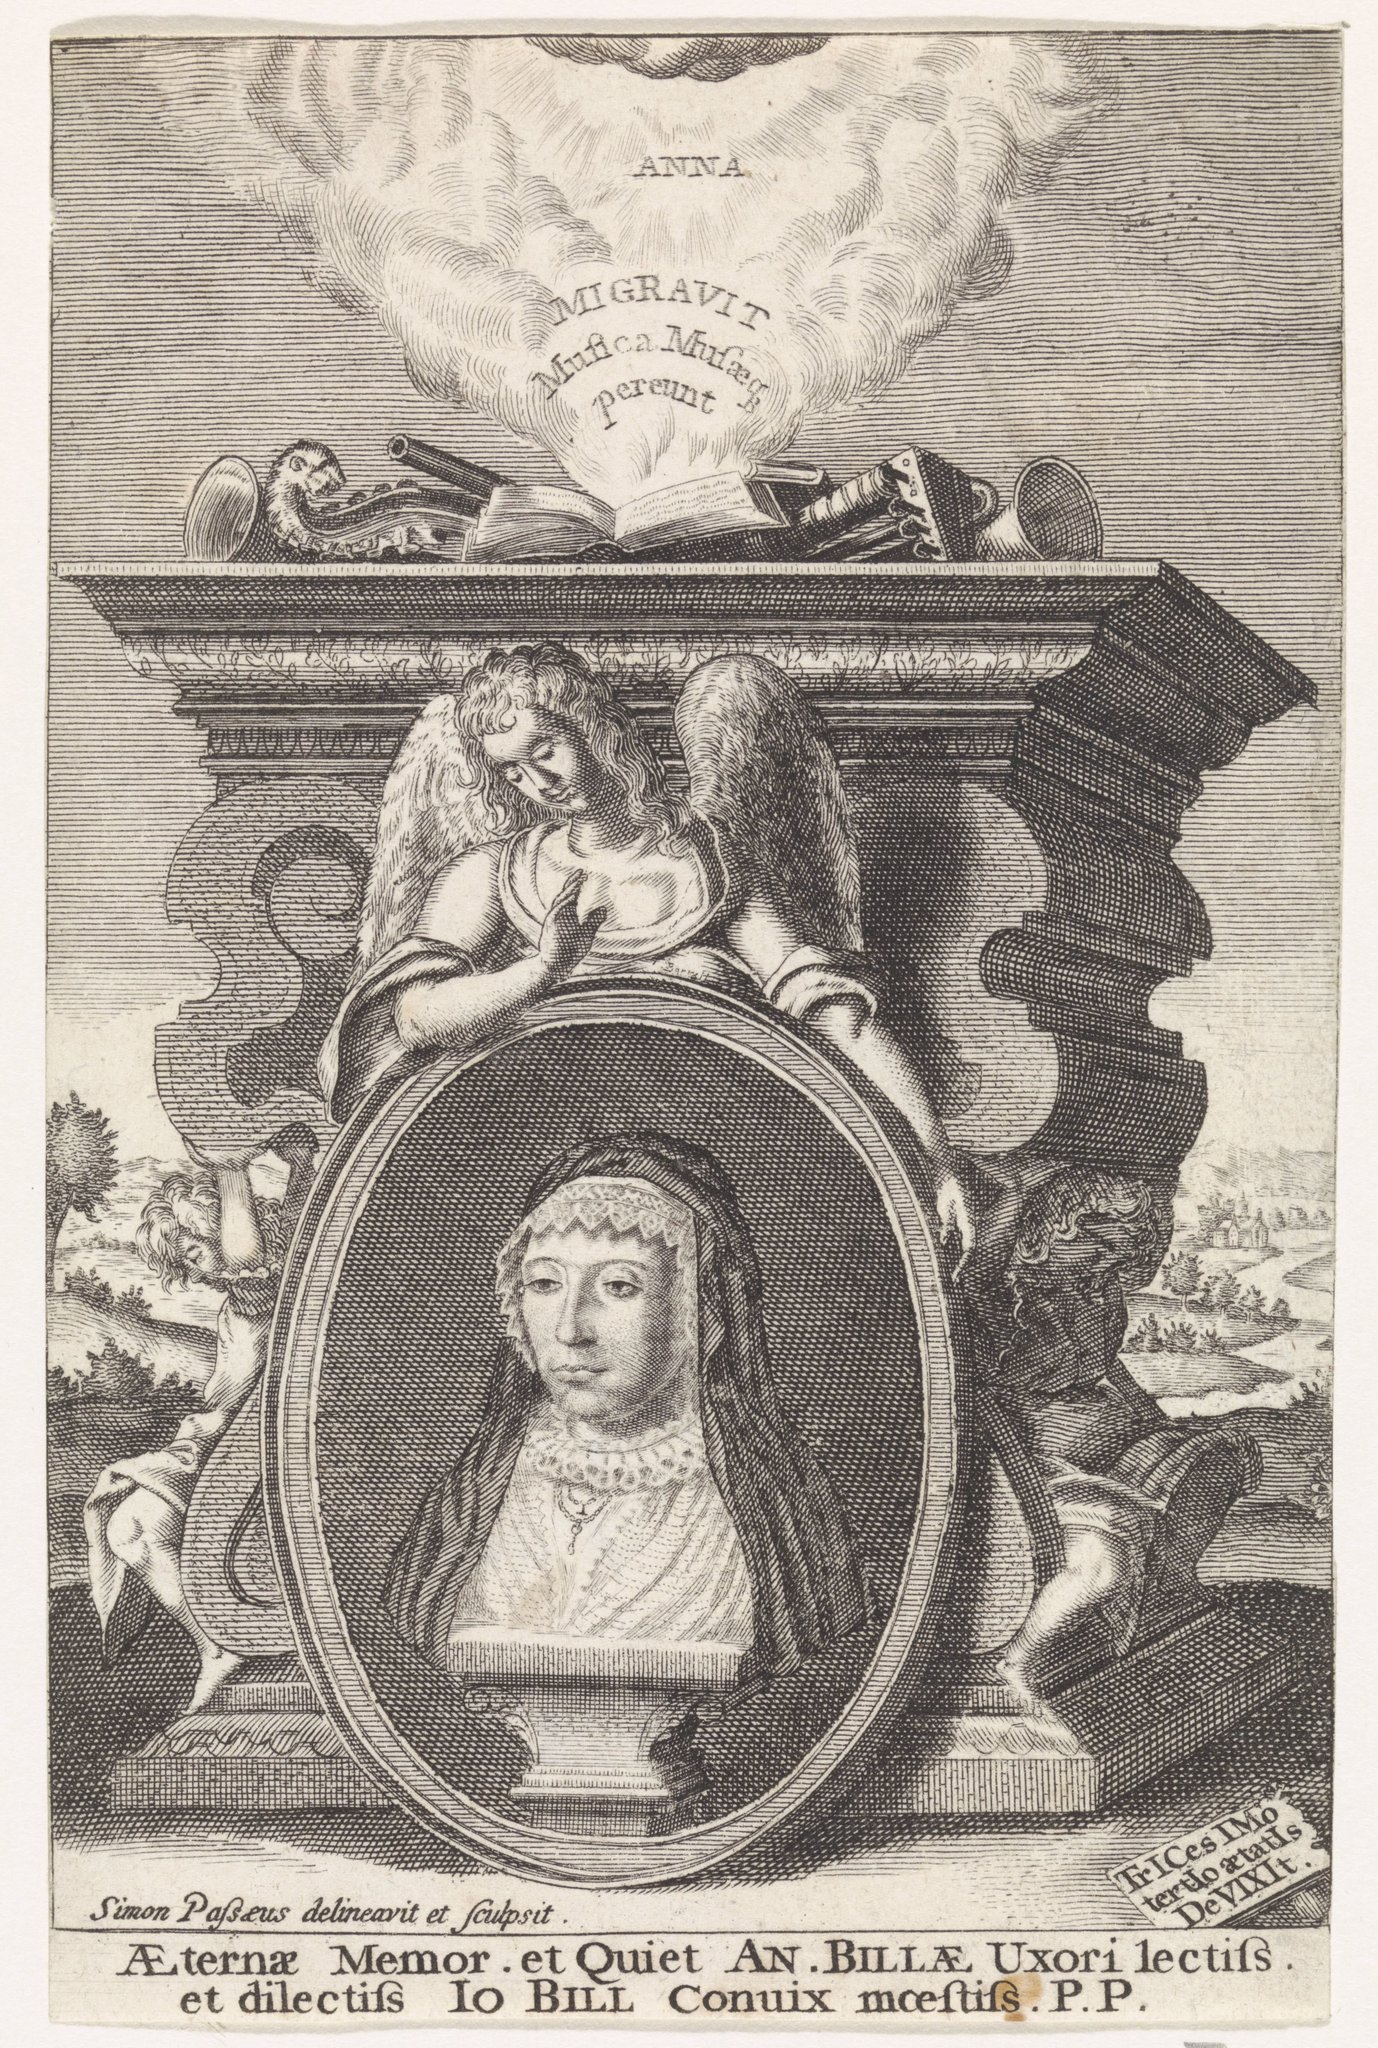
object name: print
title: Portret van Anna Bille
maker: simon van de passe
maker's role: print maker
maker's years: 1595-1647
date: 1605-1647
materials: paper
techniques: engraving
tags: musical instruments; group of musical instruments, printed edition of musical score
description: Landschap met een altaar met het portret van Anna Bille. Op het altaar liggen een opengeslagen liedboek en diverse muziekinstrumenten. Daarboven de naam van de geportretteerde en tekst in het Latijn. In de marge een tweeregelig onderschrift ter nagedachtenis aan de geportretteerde in het Latijn.